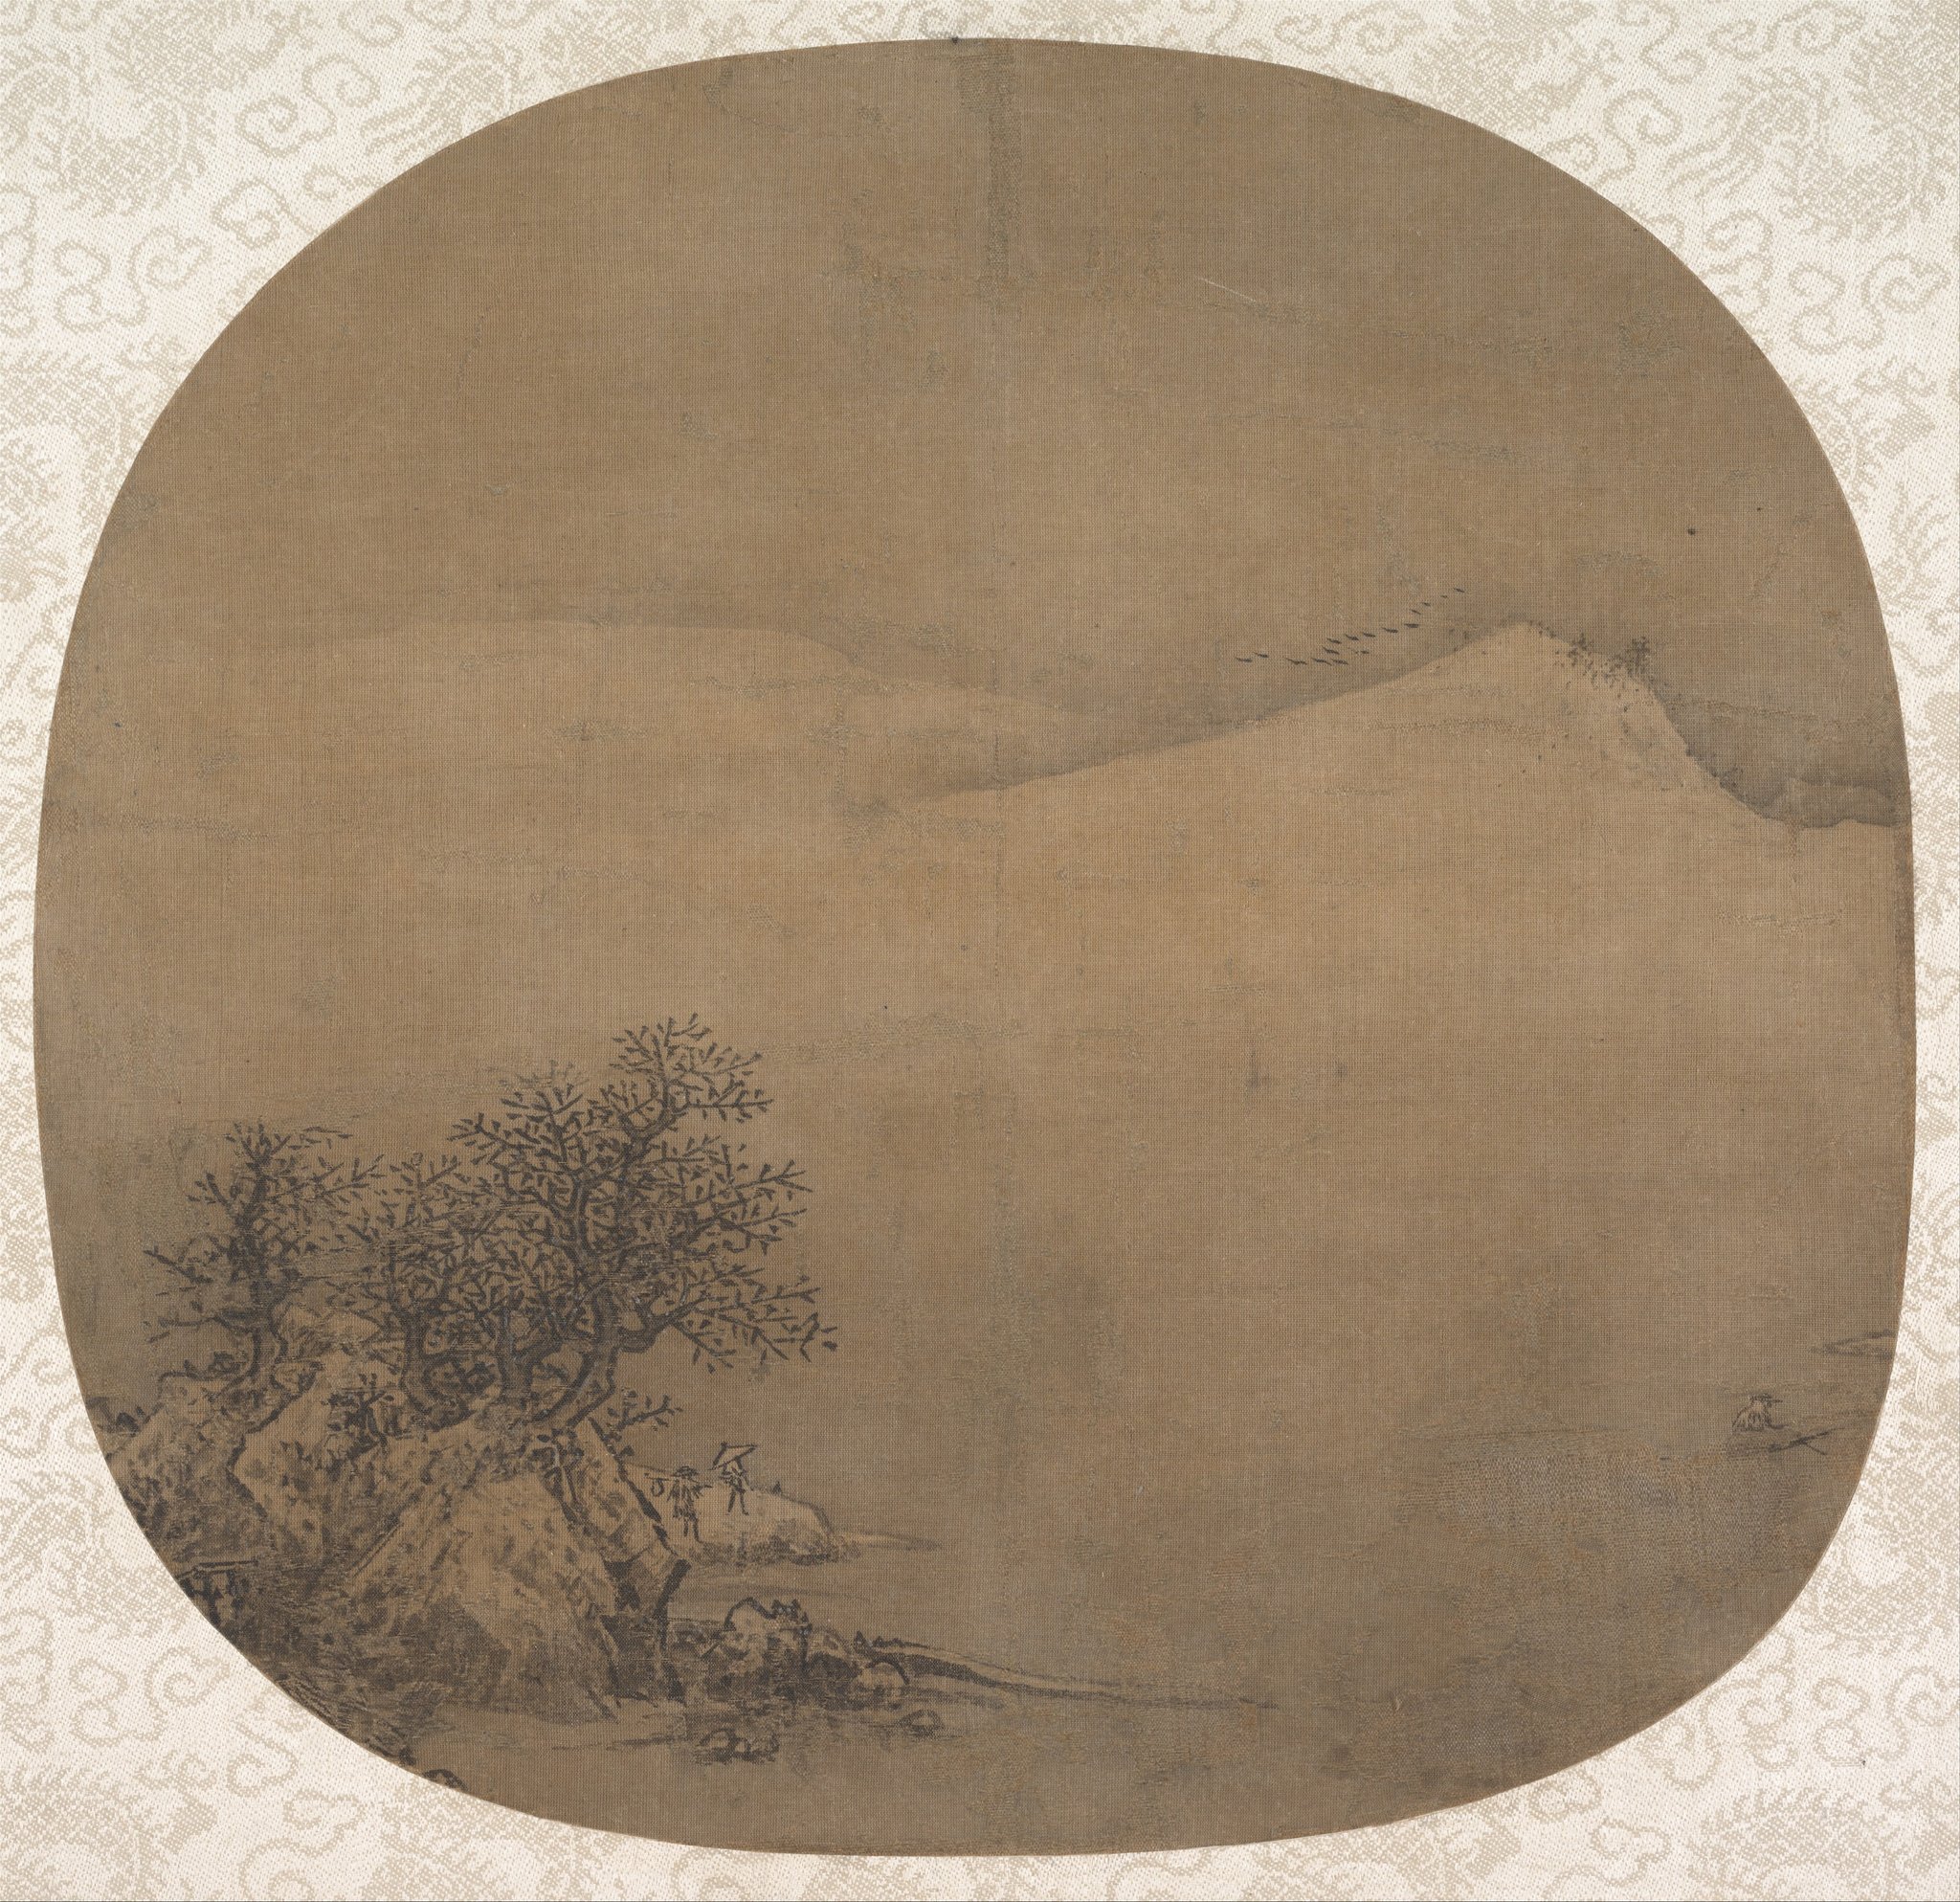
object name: fan mounted a an album leaf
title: Waiting for the Ferry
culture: chinese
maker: unidentified artist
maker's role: artist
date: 1201-1233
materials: ink, silk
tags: mountains,landscapes,snow